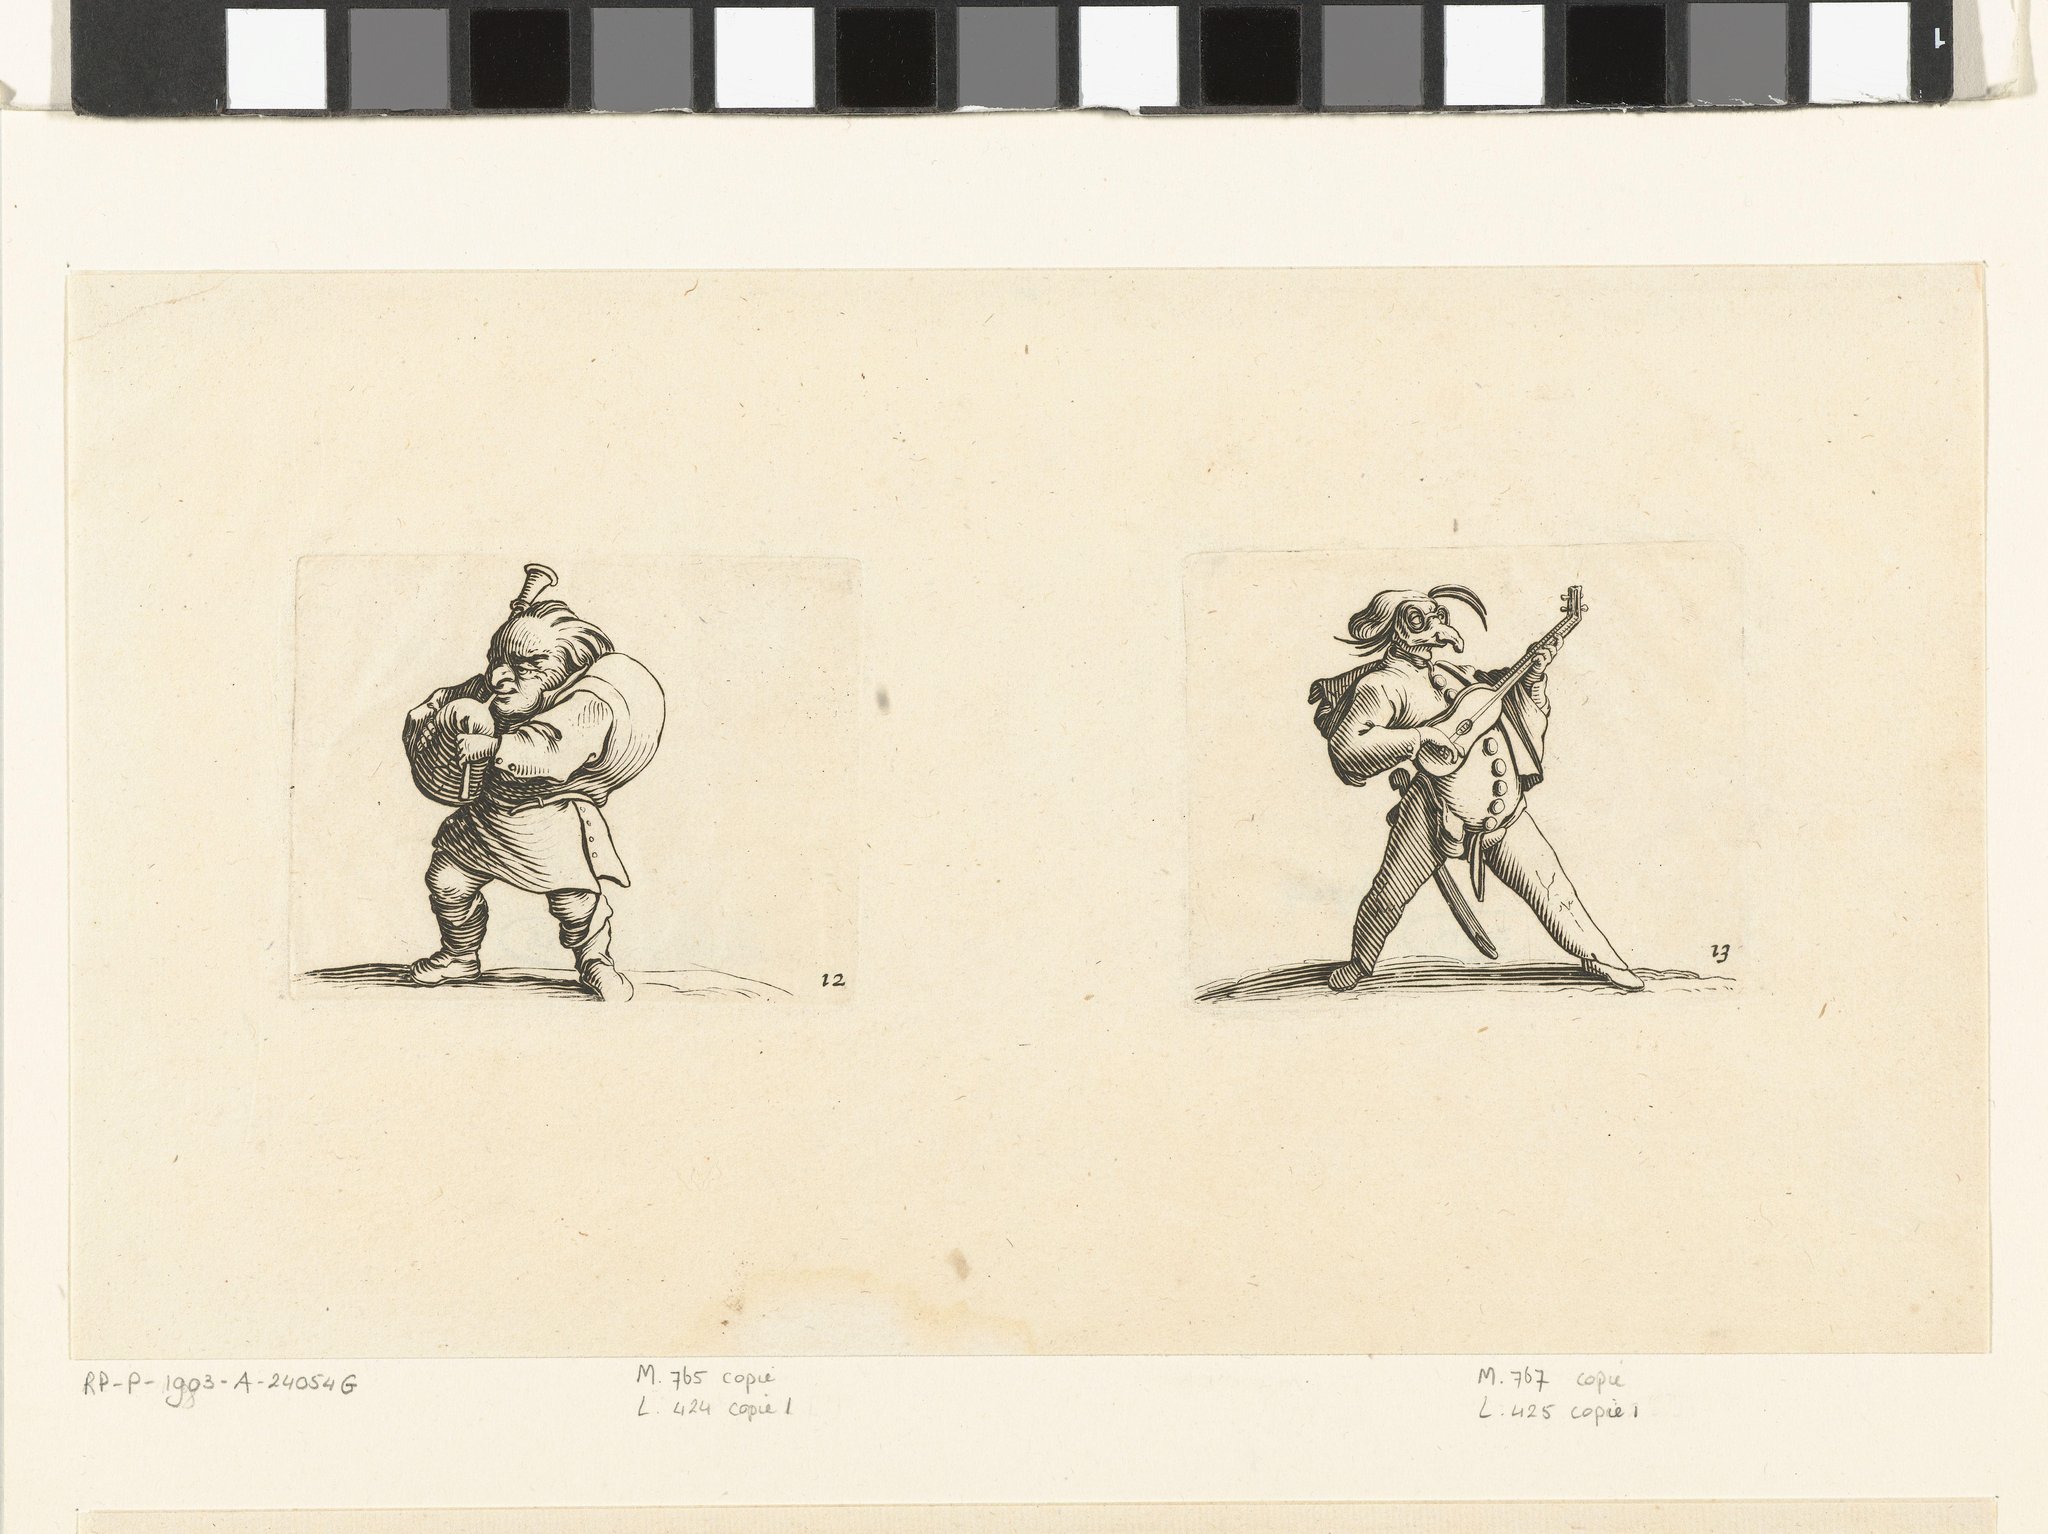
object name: print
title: Kleine mens (karikatuur) met doedelzak; commedia dell'arte-figuur met gitaar, zwaard en masker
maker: abraham bosse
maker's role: draughtsman, print maker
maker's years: 1602-1676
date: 1621-1676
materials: paper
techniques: engraving, etching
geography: paris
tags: mask, types in 'commedia dell'arte', one person playing wind instrument, little people, bagpipe, musette, hacking and thrusting weapons: sword, hunchback, one person playing string instrument (plucked), cithern, mandolin, guitar, balalaika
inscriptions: collector's mark: Lugt 2228a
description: Links: kleine mens (karikatuur), op de linkerzijde gezien, met een gebochelde rug, een doedelzak bespelend. Rechts: commedia dell'arte-figuur, van voren gezien, een gitaar bespelend, een muts met twee veren op het hoofd, een masker voor het gezicht, een zwaard aan zijn rechterzijde. Deze beide prenten, naast elkaar op 1 blad gedrukt, zijn onderdeel van een serie van 21 prenten (op 11 bladen gedrukt, dus m.u.v. de titelprent steeds 2 platen per blad) met groteske figuren; vrijwel al die figuren zijn karikaturen van kleine mensen, velen zijn gebocheld.